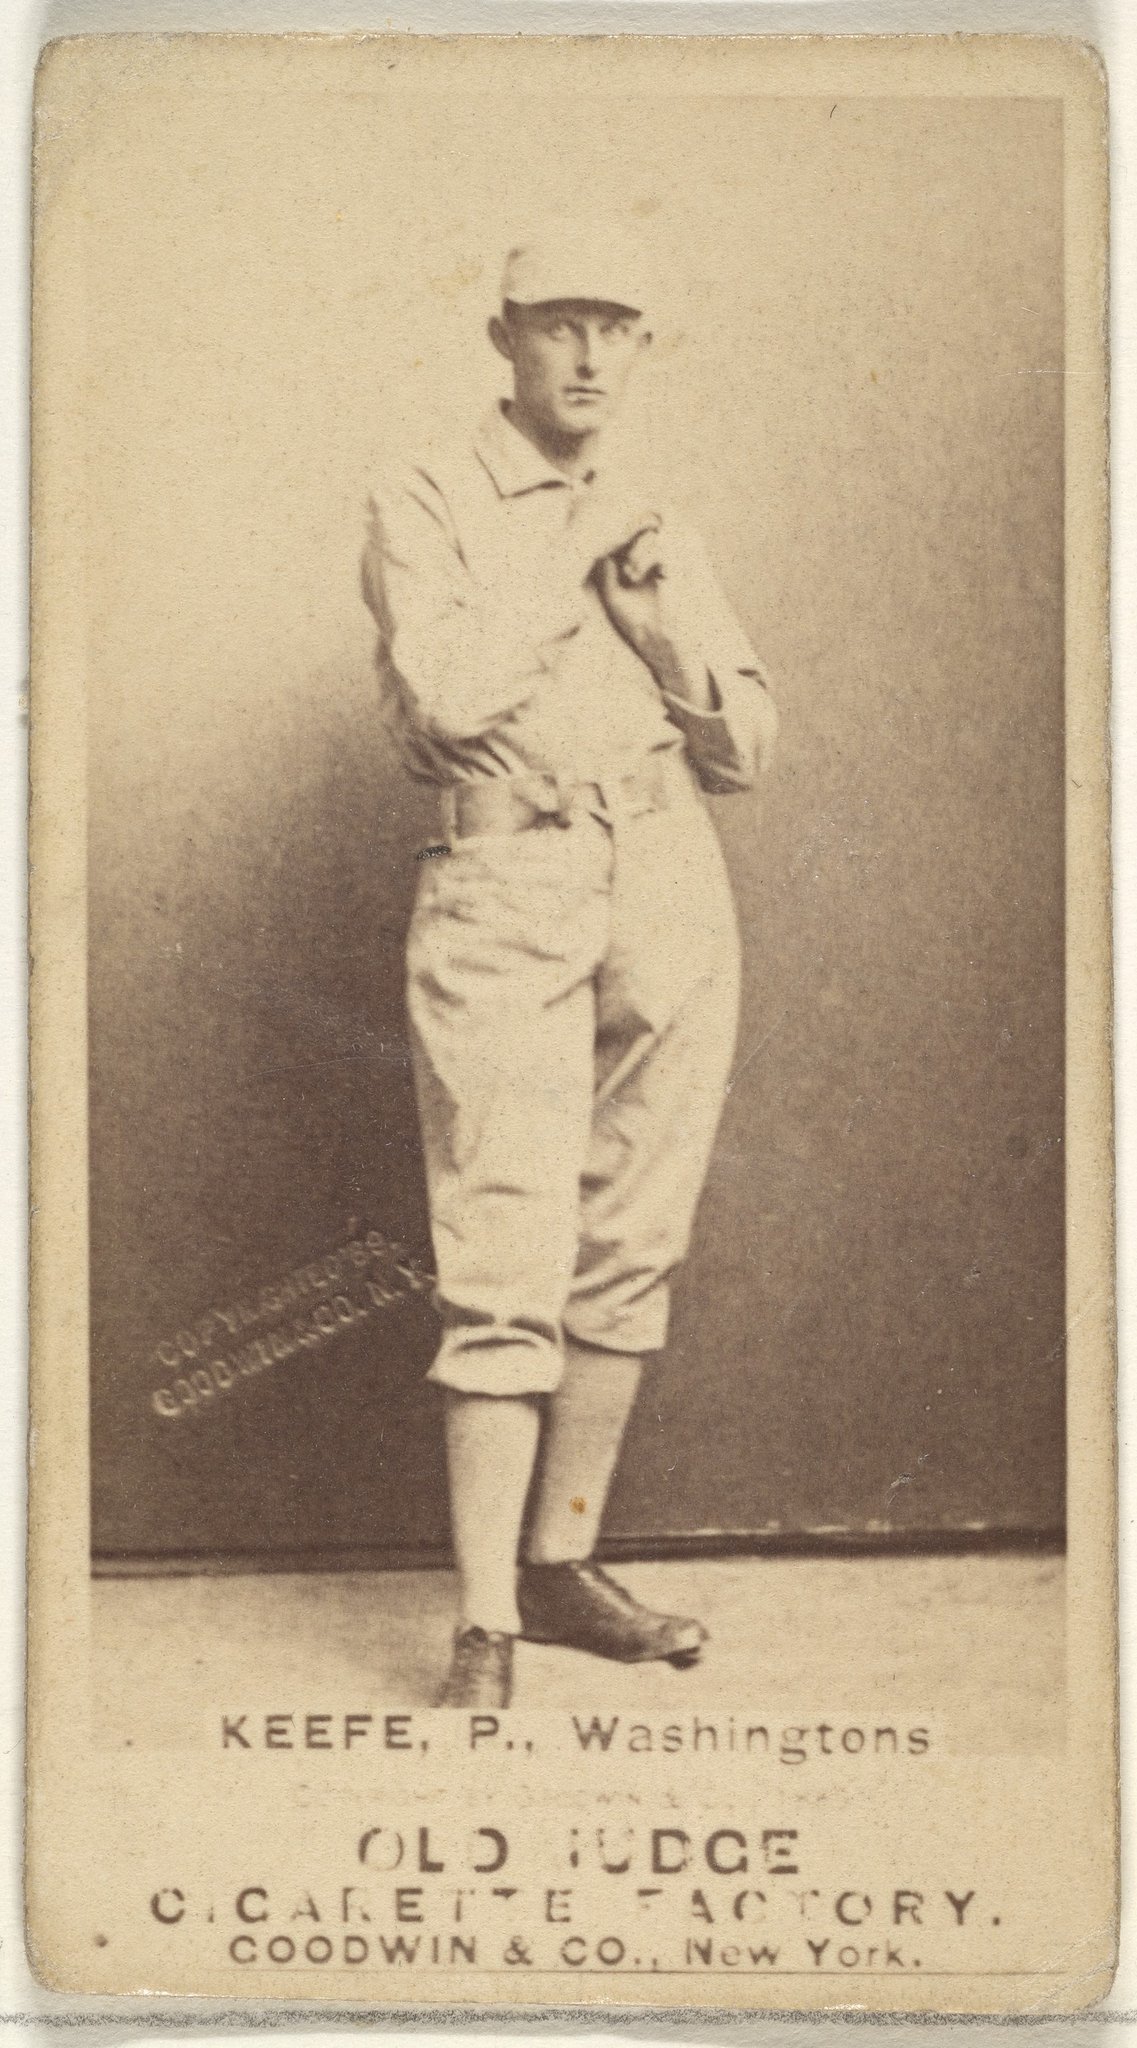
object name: baseball card, photograph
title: George Washington Keefe, Pitcher, Washington Nationals, from the Old Judge series (N172) for Old Judge Cigarettes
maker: goodwin & company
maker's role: publisher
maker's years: 1850-1950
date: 1889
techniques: albumen silver print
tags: men,portraits,baseball,athletes